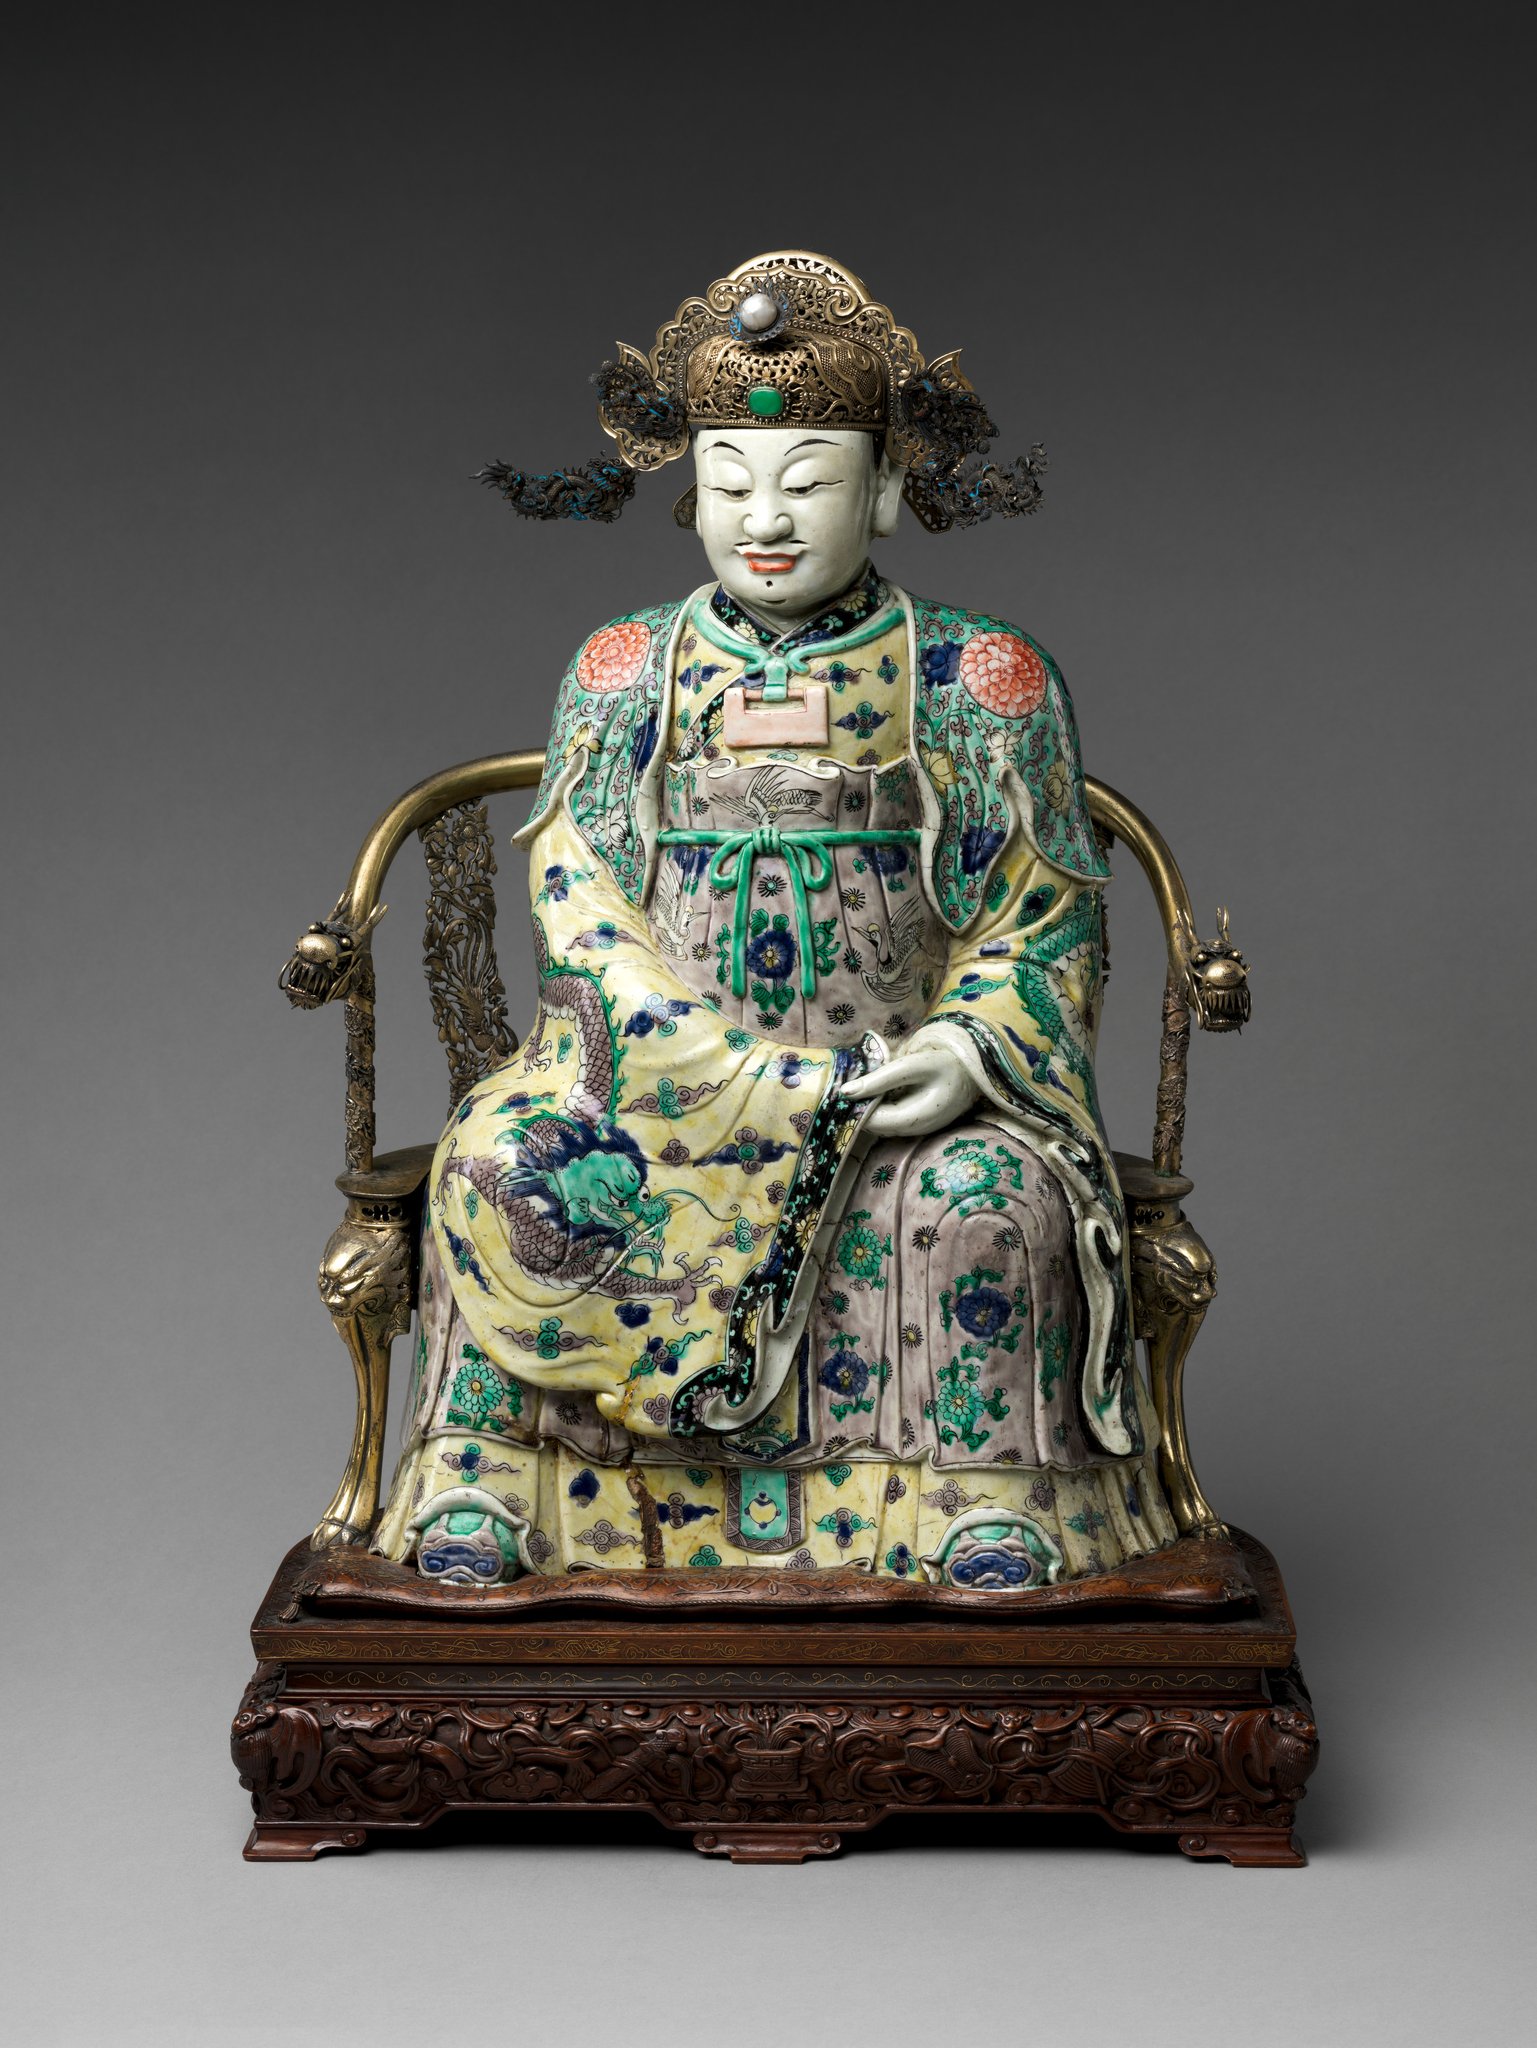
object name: figure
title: Figure, possibly the God of Wealth in His Civil Aspect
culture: chinese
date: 1667-1733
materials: biscuit, enamel, glaze, porcelain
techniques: painting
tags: men